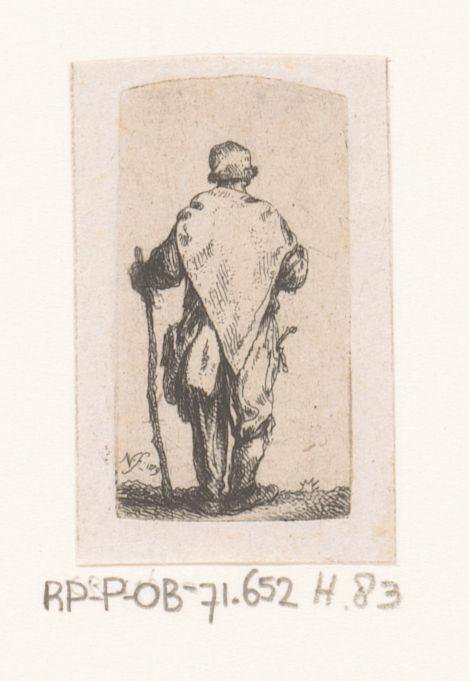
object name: print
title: Man met driehoekige cape en wandelstok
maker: jean pierre norblin de la gourdaine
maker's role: print maker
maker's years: 1745-1830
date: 1779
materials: paper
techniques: etching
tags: cape, walking-stick, staff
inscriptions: date